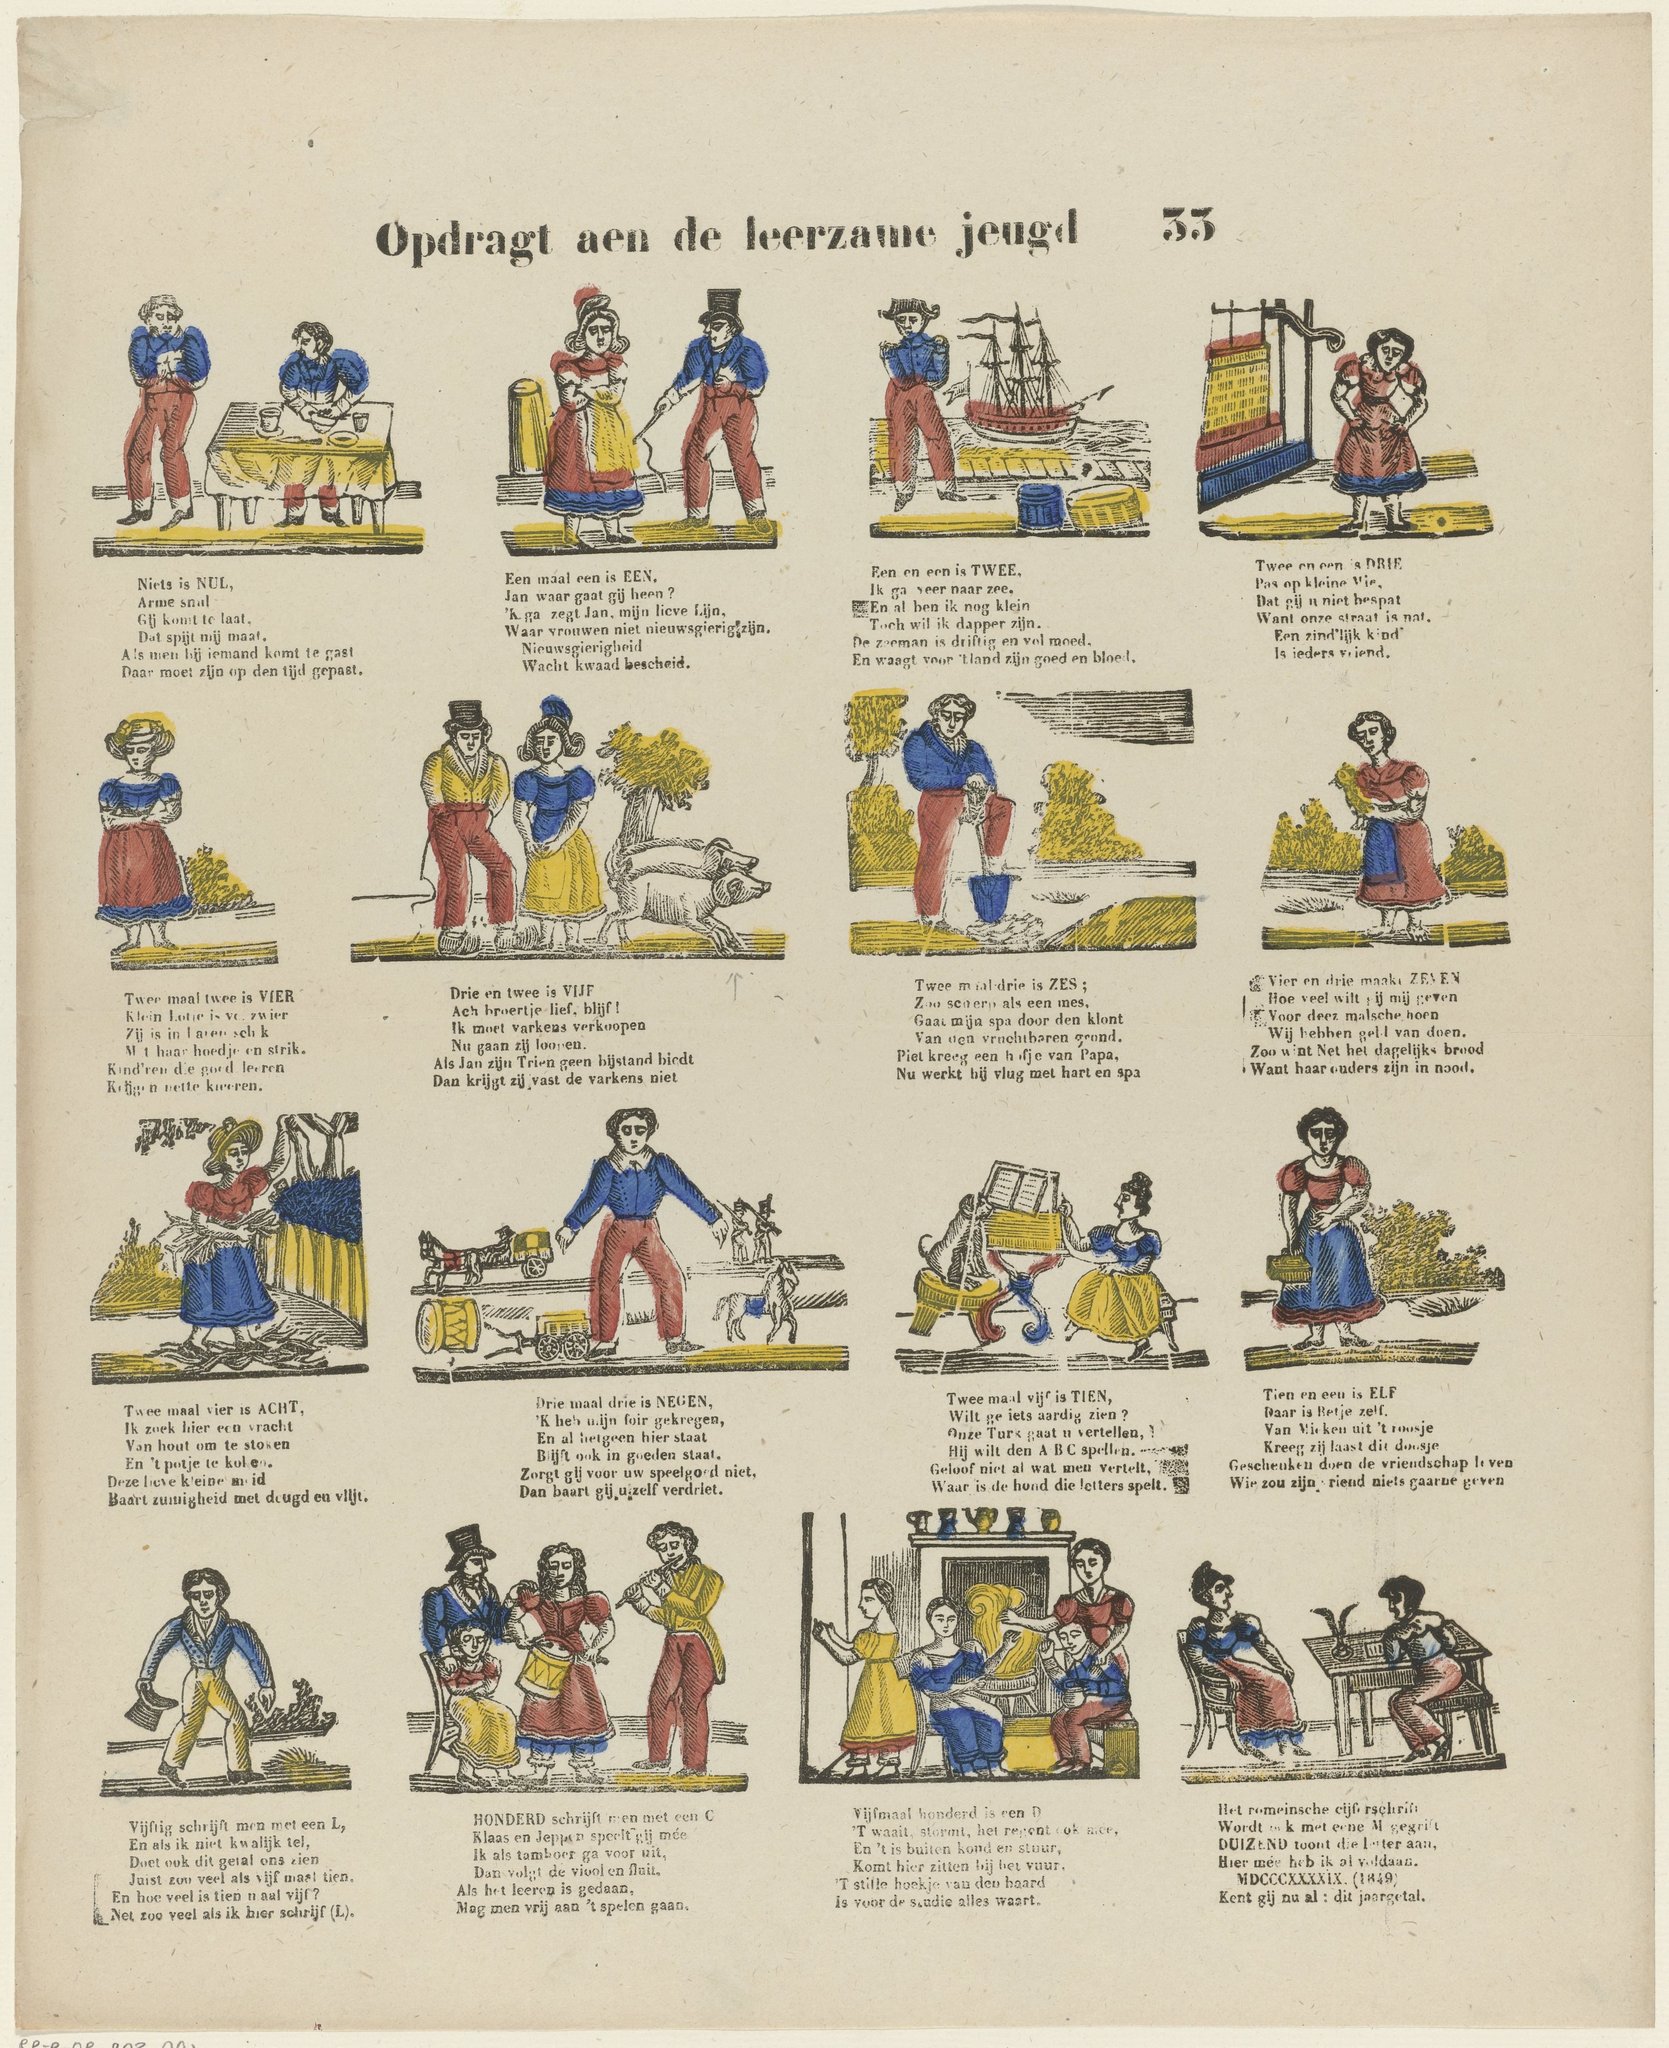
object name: print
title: Opdragt aen de leerzame jeugd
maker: Anonymous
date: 1856-1900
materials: paper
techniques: colour, letterpress printing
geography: turnhout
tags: characters (human types), counting, calculating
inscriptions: collector's mark: Lugt 2760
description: Blad met 16 voorstellingen van verschillende figuren. Onder elke afbeelding een versje met een rekensom. Genummerd rechtsboven: 33.